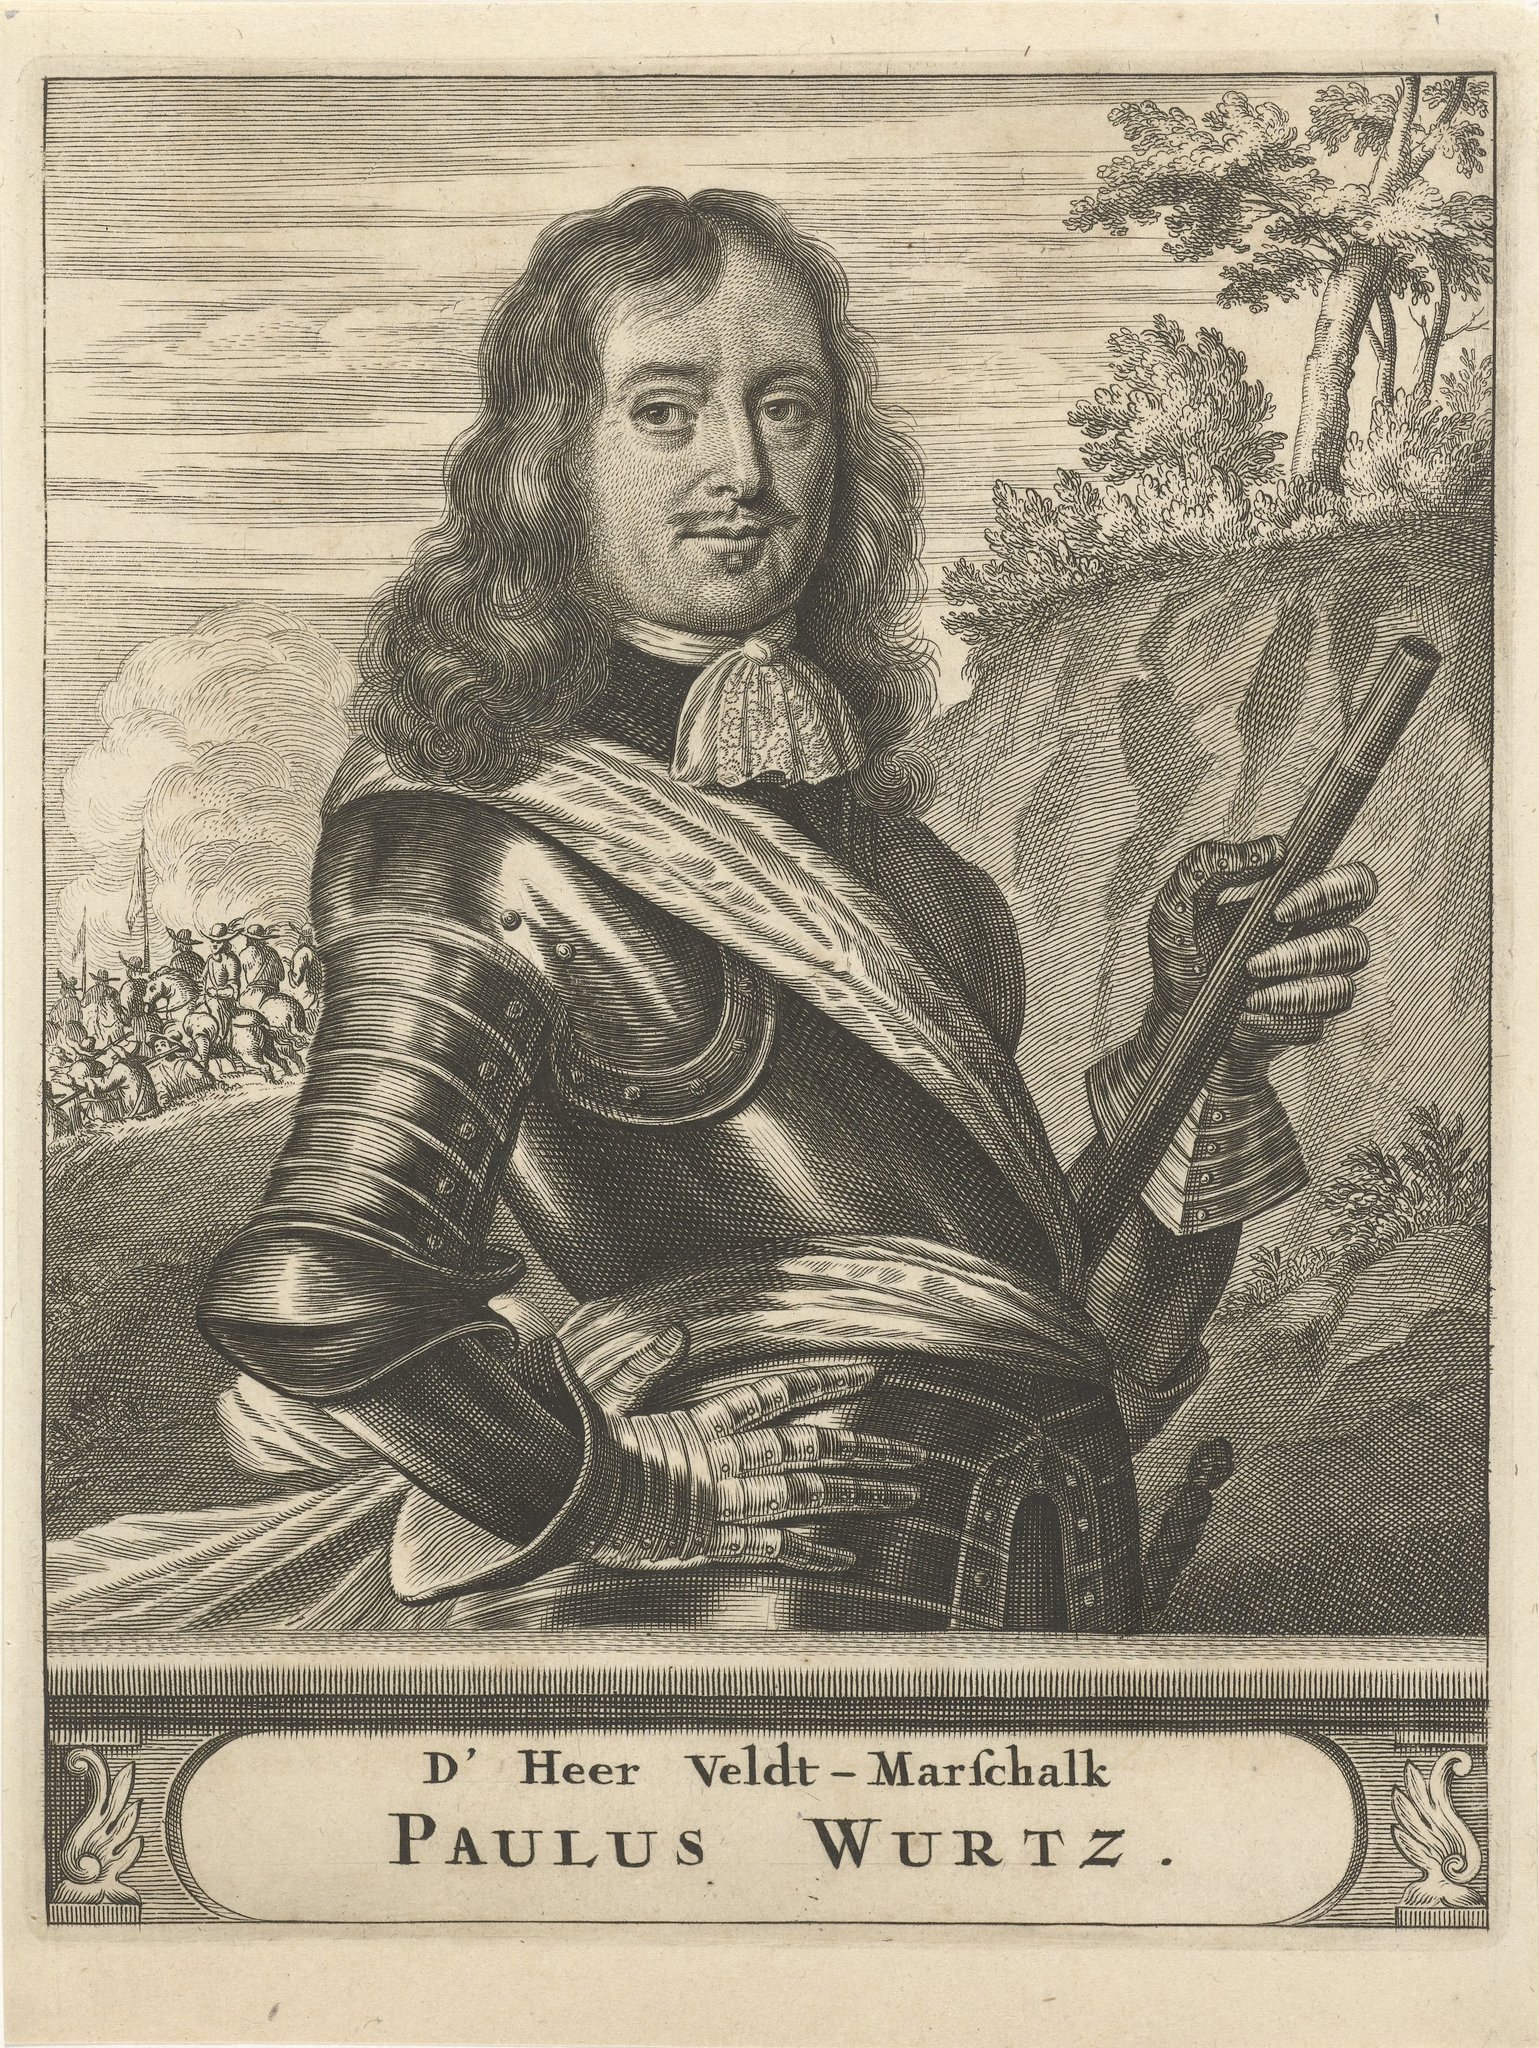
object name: print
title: Portret van Paul Wurz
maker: christiaan hagen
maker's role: draughtsman, print maker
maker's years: 1635-1707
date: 1663-1695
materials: paper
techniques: engraving, etching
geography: amsterdam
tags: belt, girdle, waistband, armour, battle, shoulder-belt, bandoleer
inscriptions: collector's mark: Lugt 2228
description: Portret ten halven lijve naar rechts van Paul Wurz, gekleed in een harnas. In zijn linkerhand houdt hij een commandostaf. Op de achtergrond is een veldslag afgebeeld. Onder zijn portret een plint, waarop zijn naam en titel in twee regels in een cartouche.